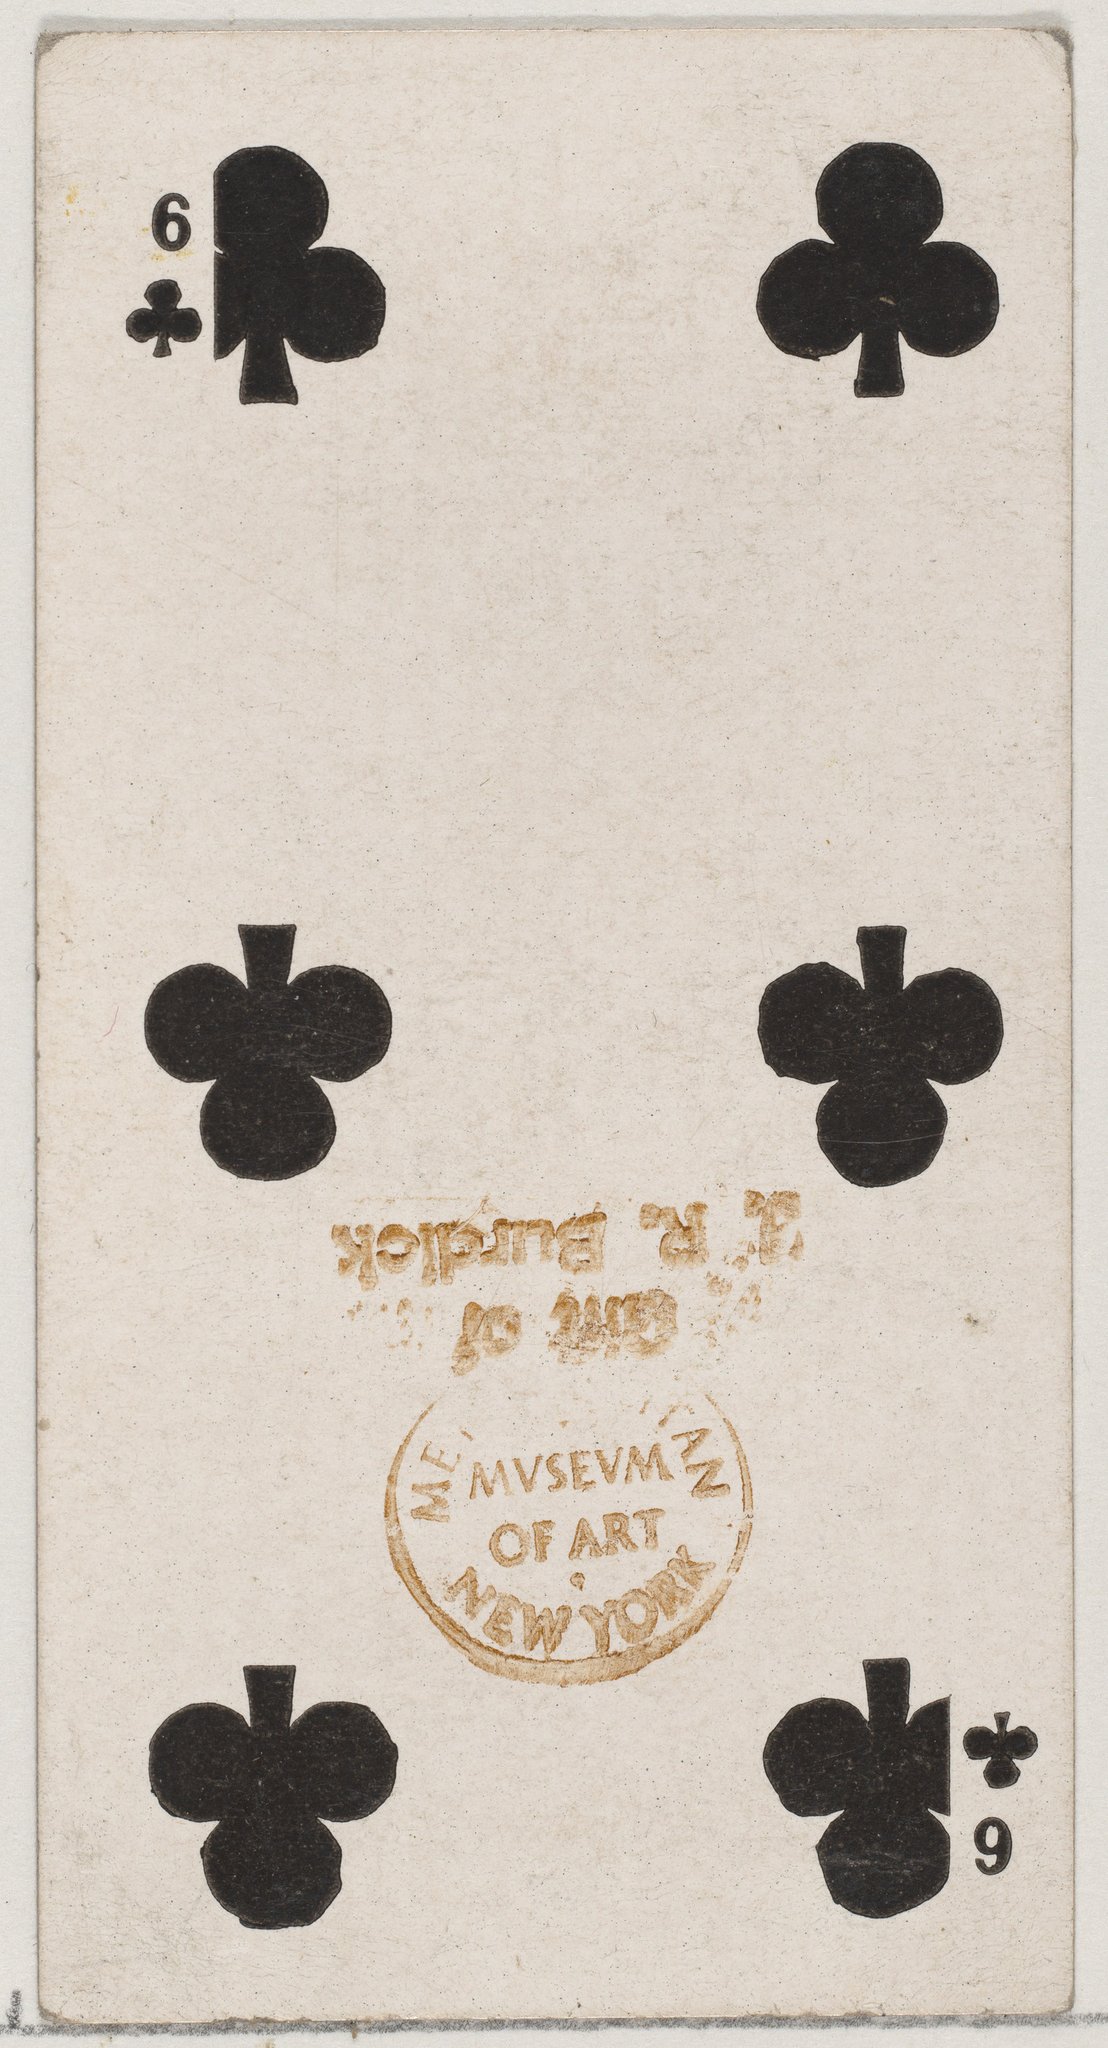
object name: print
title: Six Clubs (black), from the Playing Cards series (N84) for Duke brand cigarettes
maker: w. duke, sons & co.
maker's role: publisher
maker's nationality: american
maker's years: 1870-1920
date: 1888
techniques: color lithograph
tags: playing cards